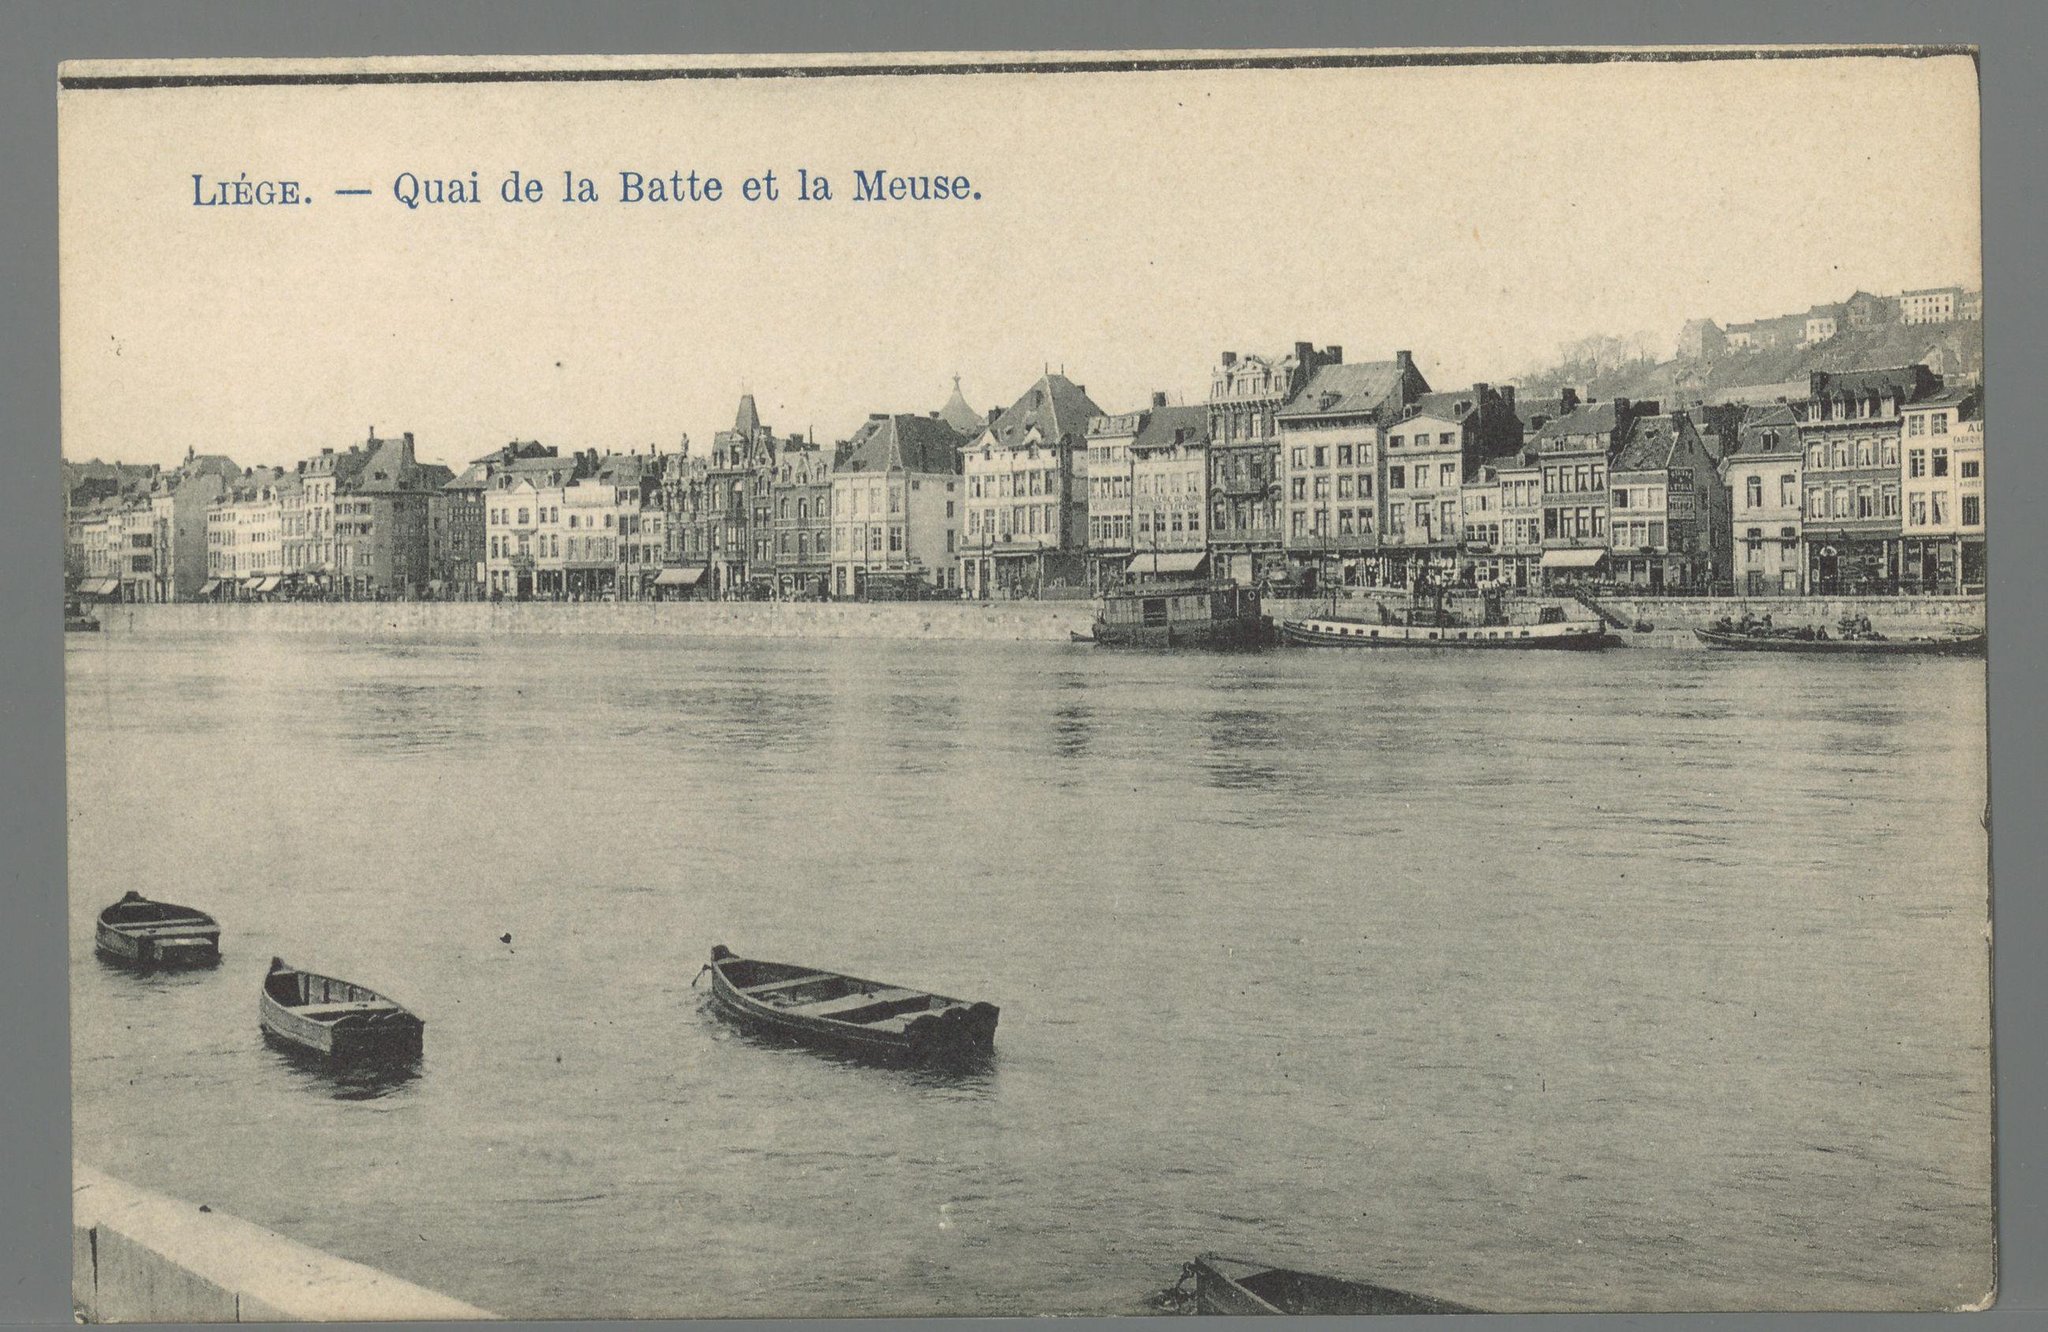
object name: photomechanical print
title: Liège. Quai de la Batte et la Meuse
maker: Anonymous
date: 1892-1906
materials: cardboard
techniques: photograph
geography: liège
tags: city-view, and landscape with man-made constructions, ships (in general), quay, liège